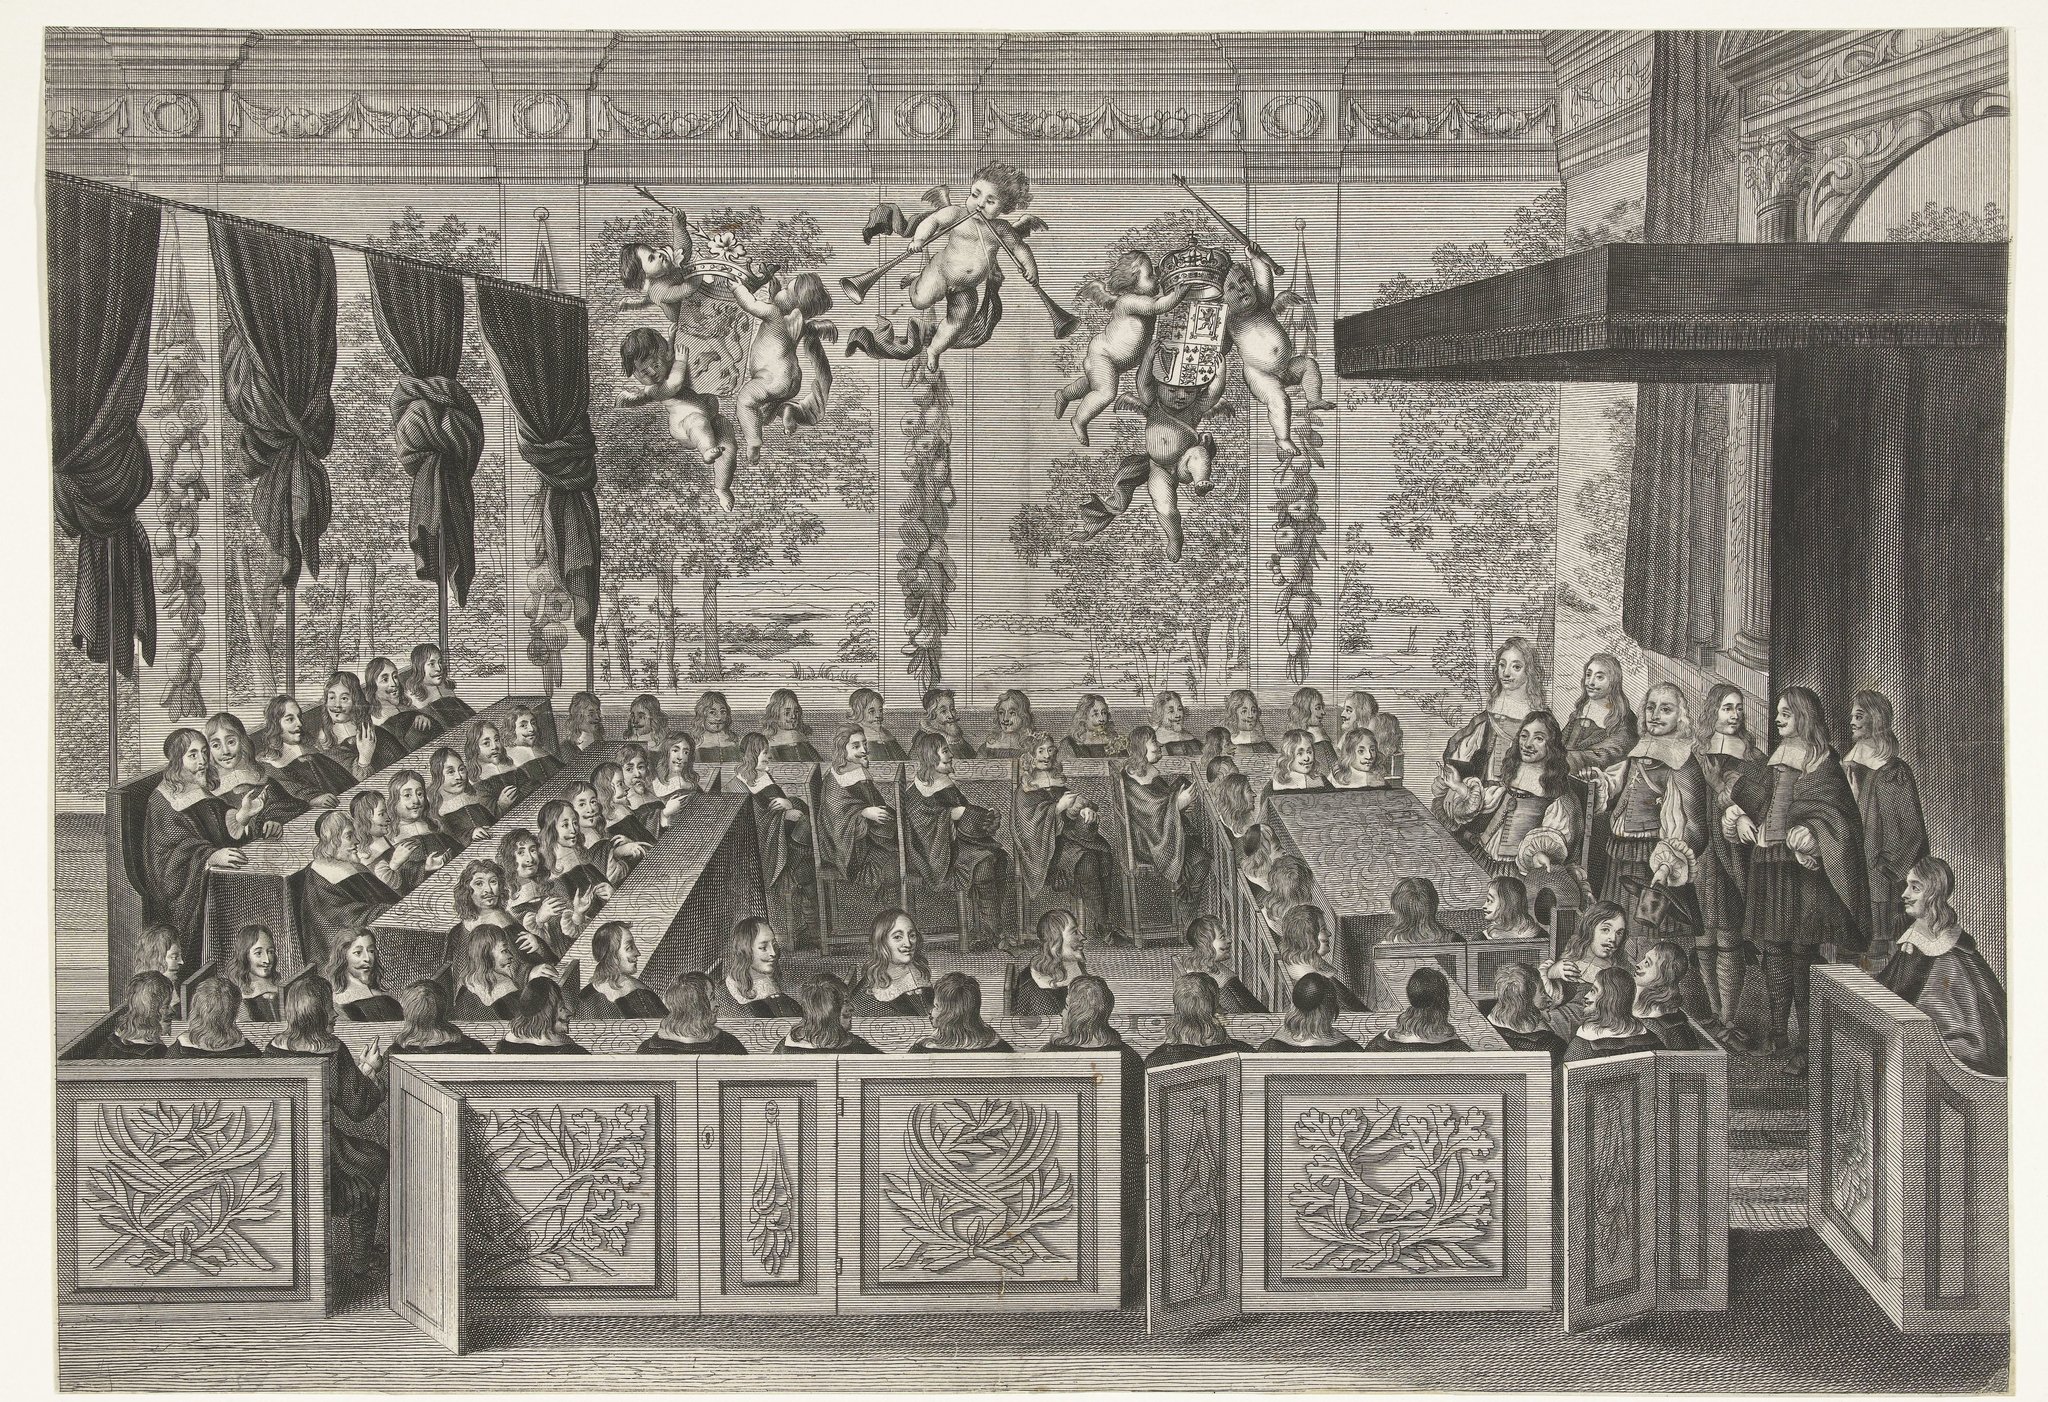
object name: print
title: Koning Karel II van Engeland spreekt de zittende leden van de Staten-Generaal toe, 1660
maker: anthony van zijlvelt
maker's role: print maker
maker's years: 1637-1715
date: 1660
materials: paper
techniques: engraving, etching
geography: northern netherlands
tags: london, karel ii (koning van engeland), festivities (+ speech, address ~ festive activities)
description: Koning Karel II van Engeland spreekt de Staten-Generaal toe, 1 juni 1660. Episode tijdens zijn rondreis door en vertrek uit de Nederlanden. Rechts de koning rechts met begeleiders zittend onder een baldakijn achter een tafel. In de lucht putti met de wapens van Holland en de koning van Engeland. De muren bekleed met landschapstaferelen.